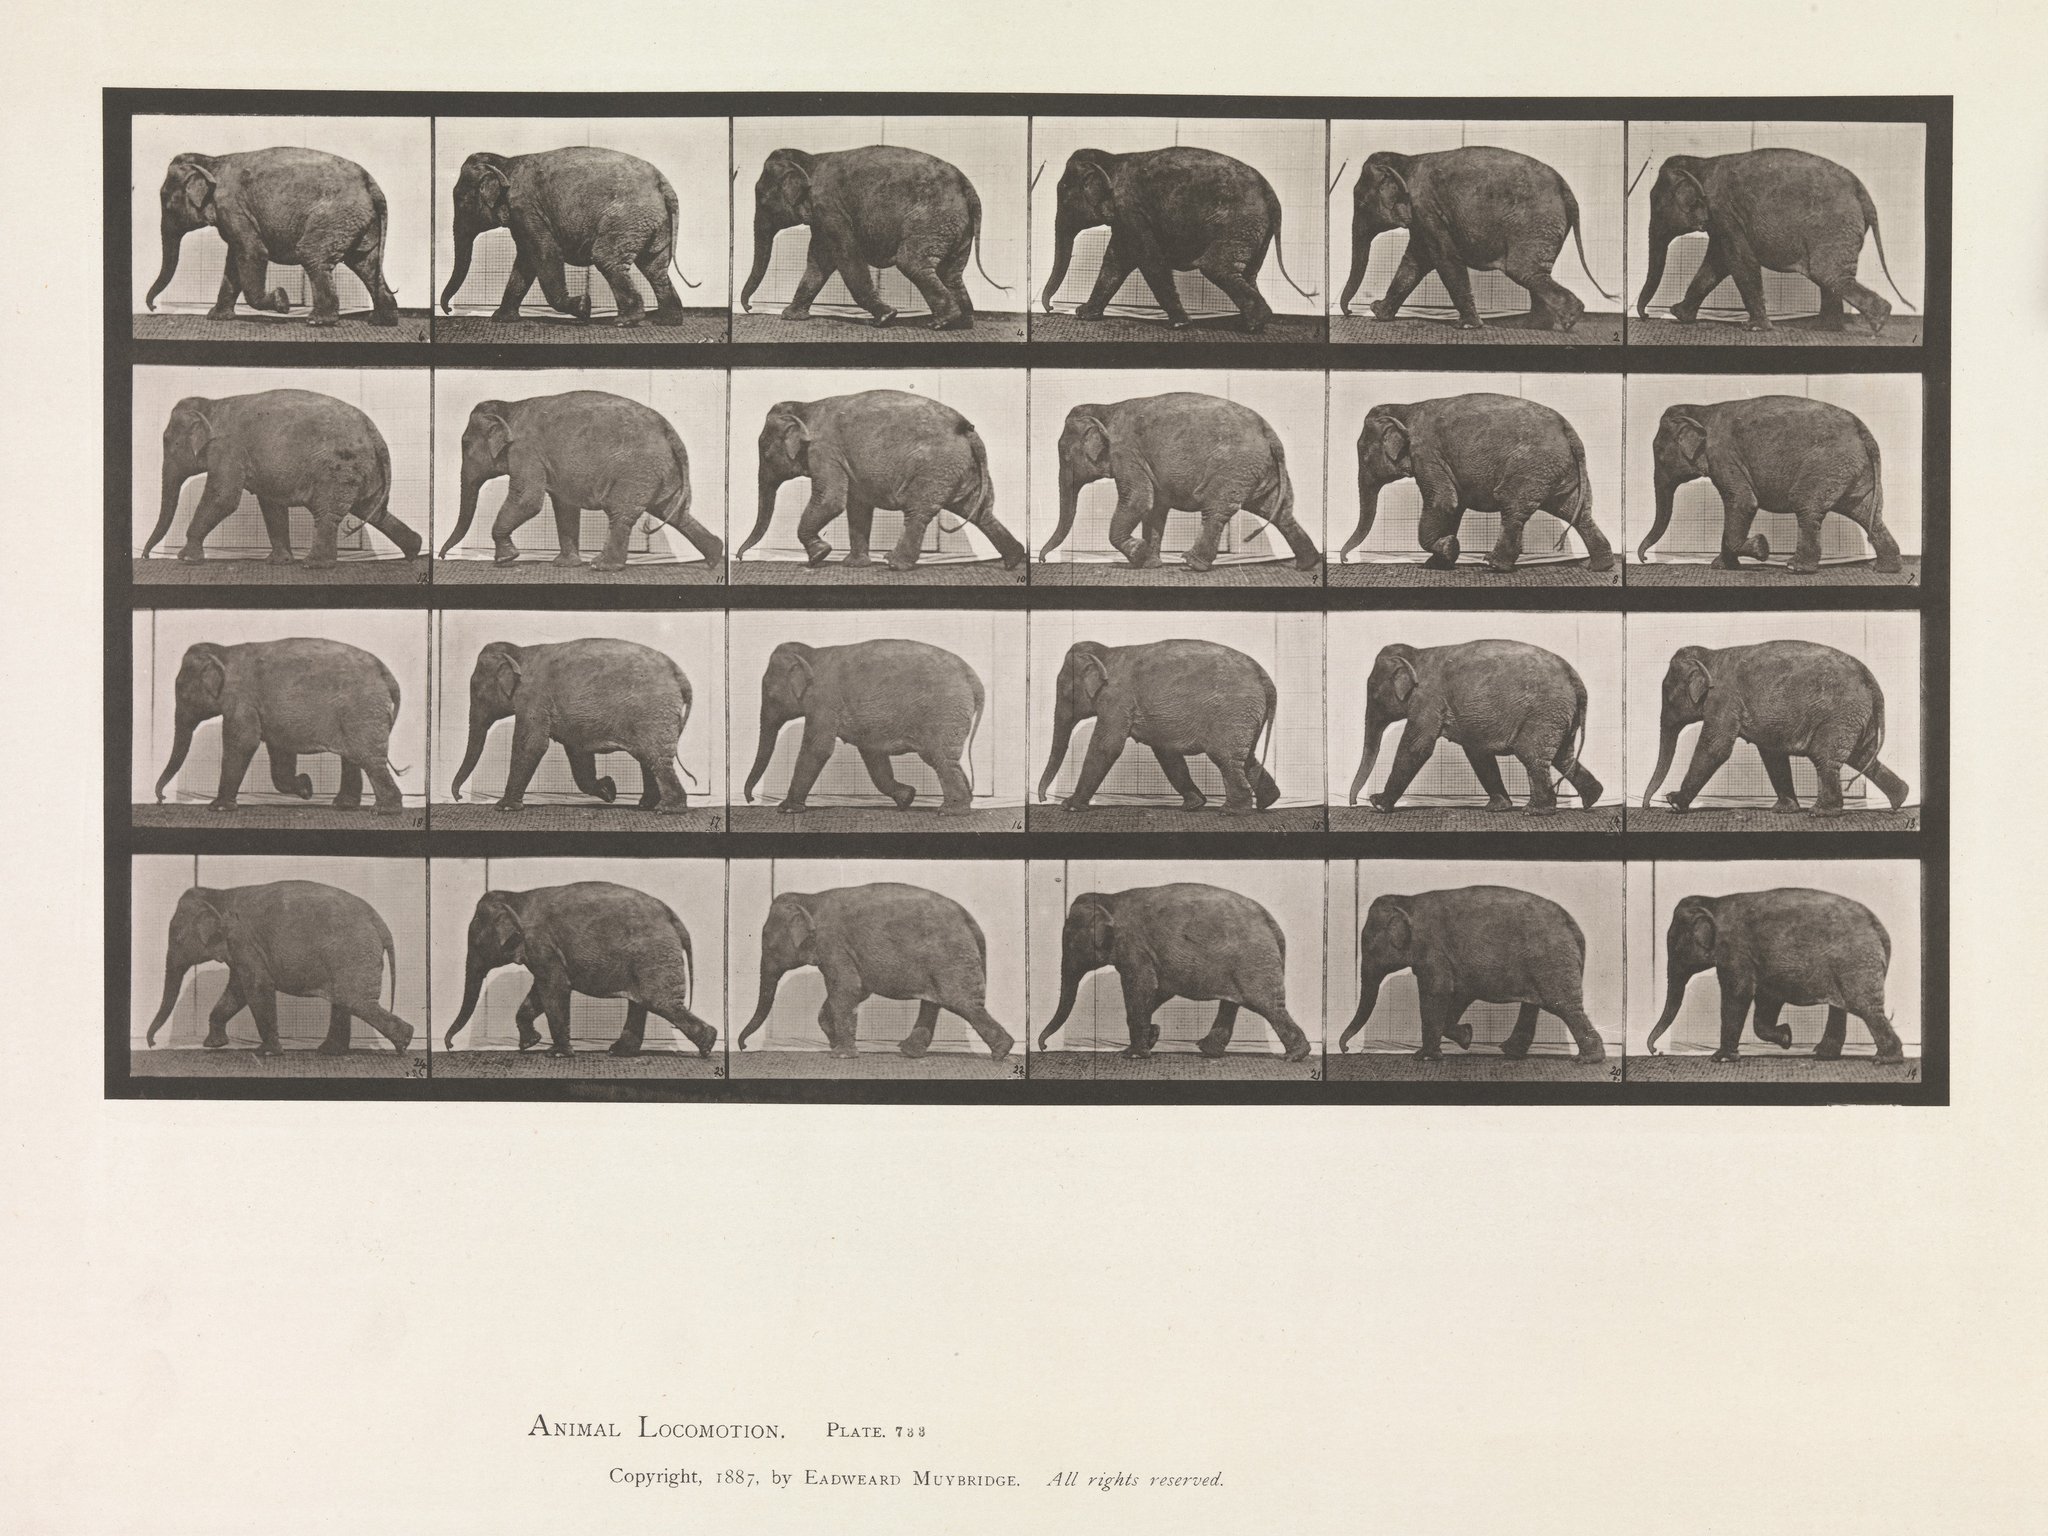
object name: photographically illustrated book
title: Animal Locomotion. An Electro-Photographic Investigation of Consecutive Phases of Animal Movements. Commenced 1872 - Completed 1885. Volume XI, Wild Animals and Birds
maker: eadweard muybridge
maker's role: artist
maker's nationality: british and american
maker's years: 1830-1904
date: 1880-1889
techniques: photogravure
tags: birds,elephants